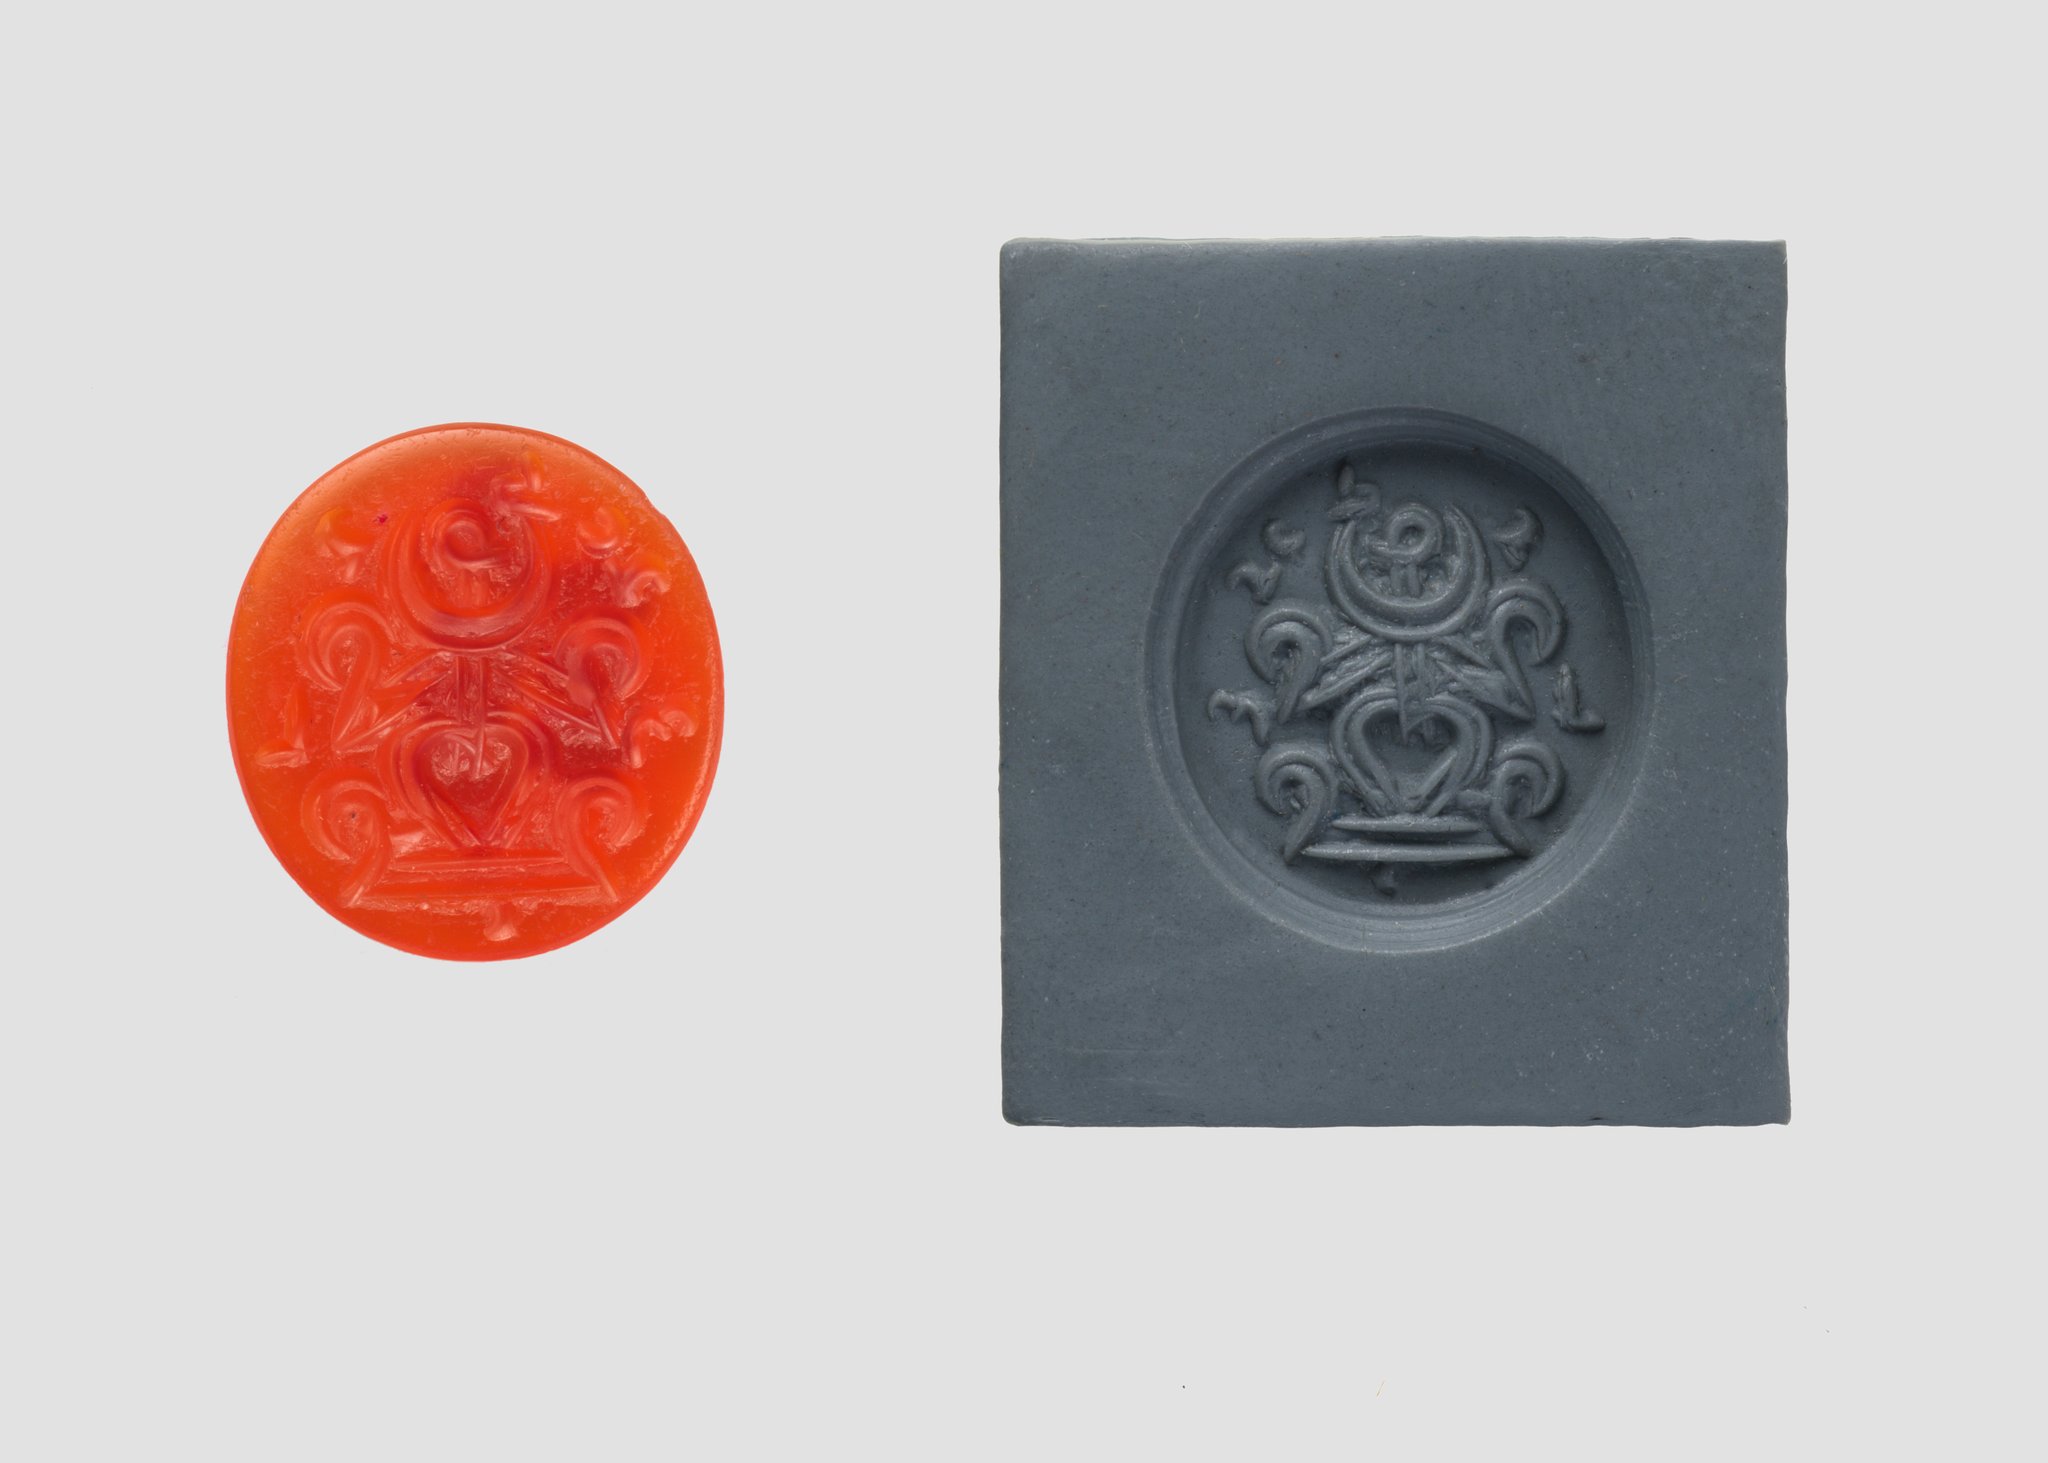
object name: stamp seal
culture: sasanian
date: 201-700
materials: gemstone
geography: iran or mesopotamia